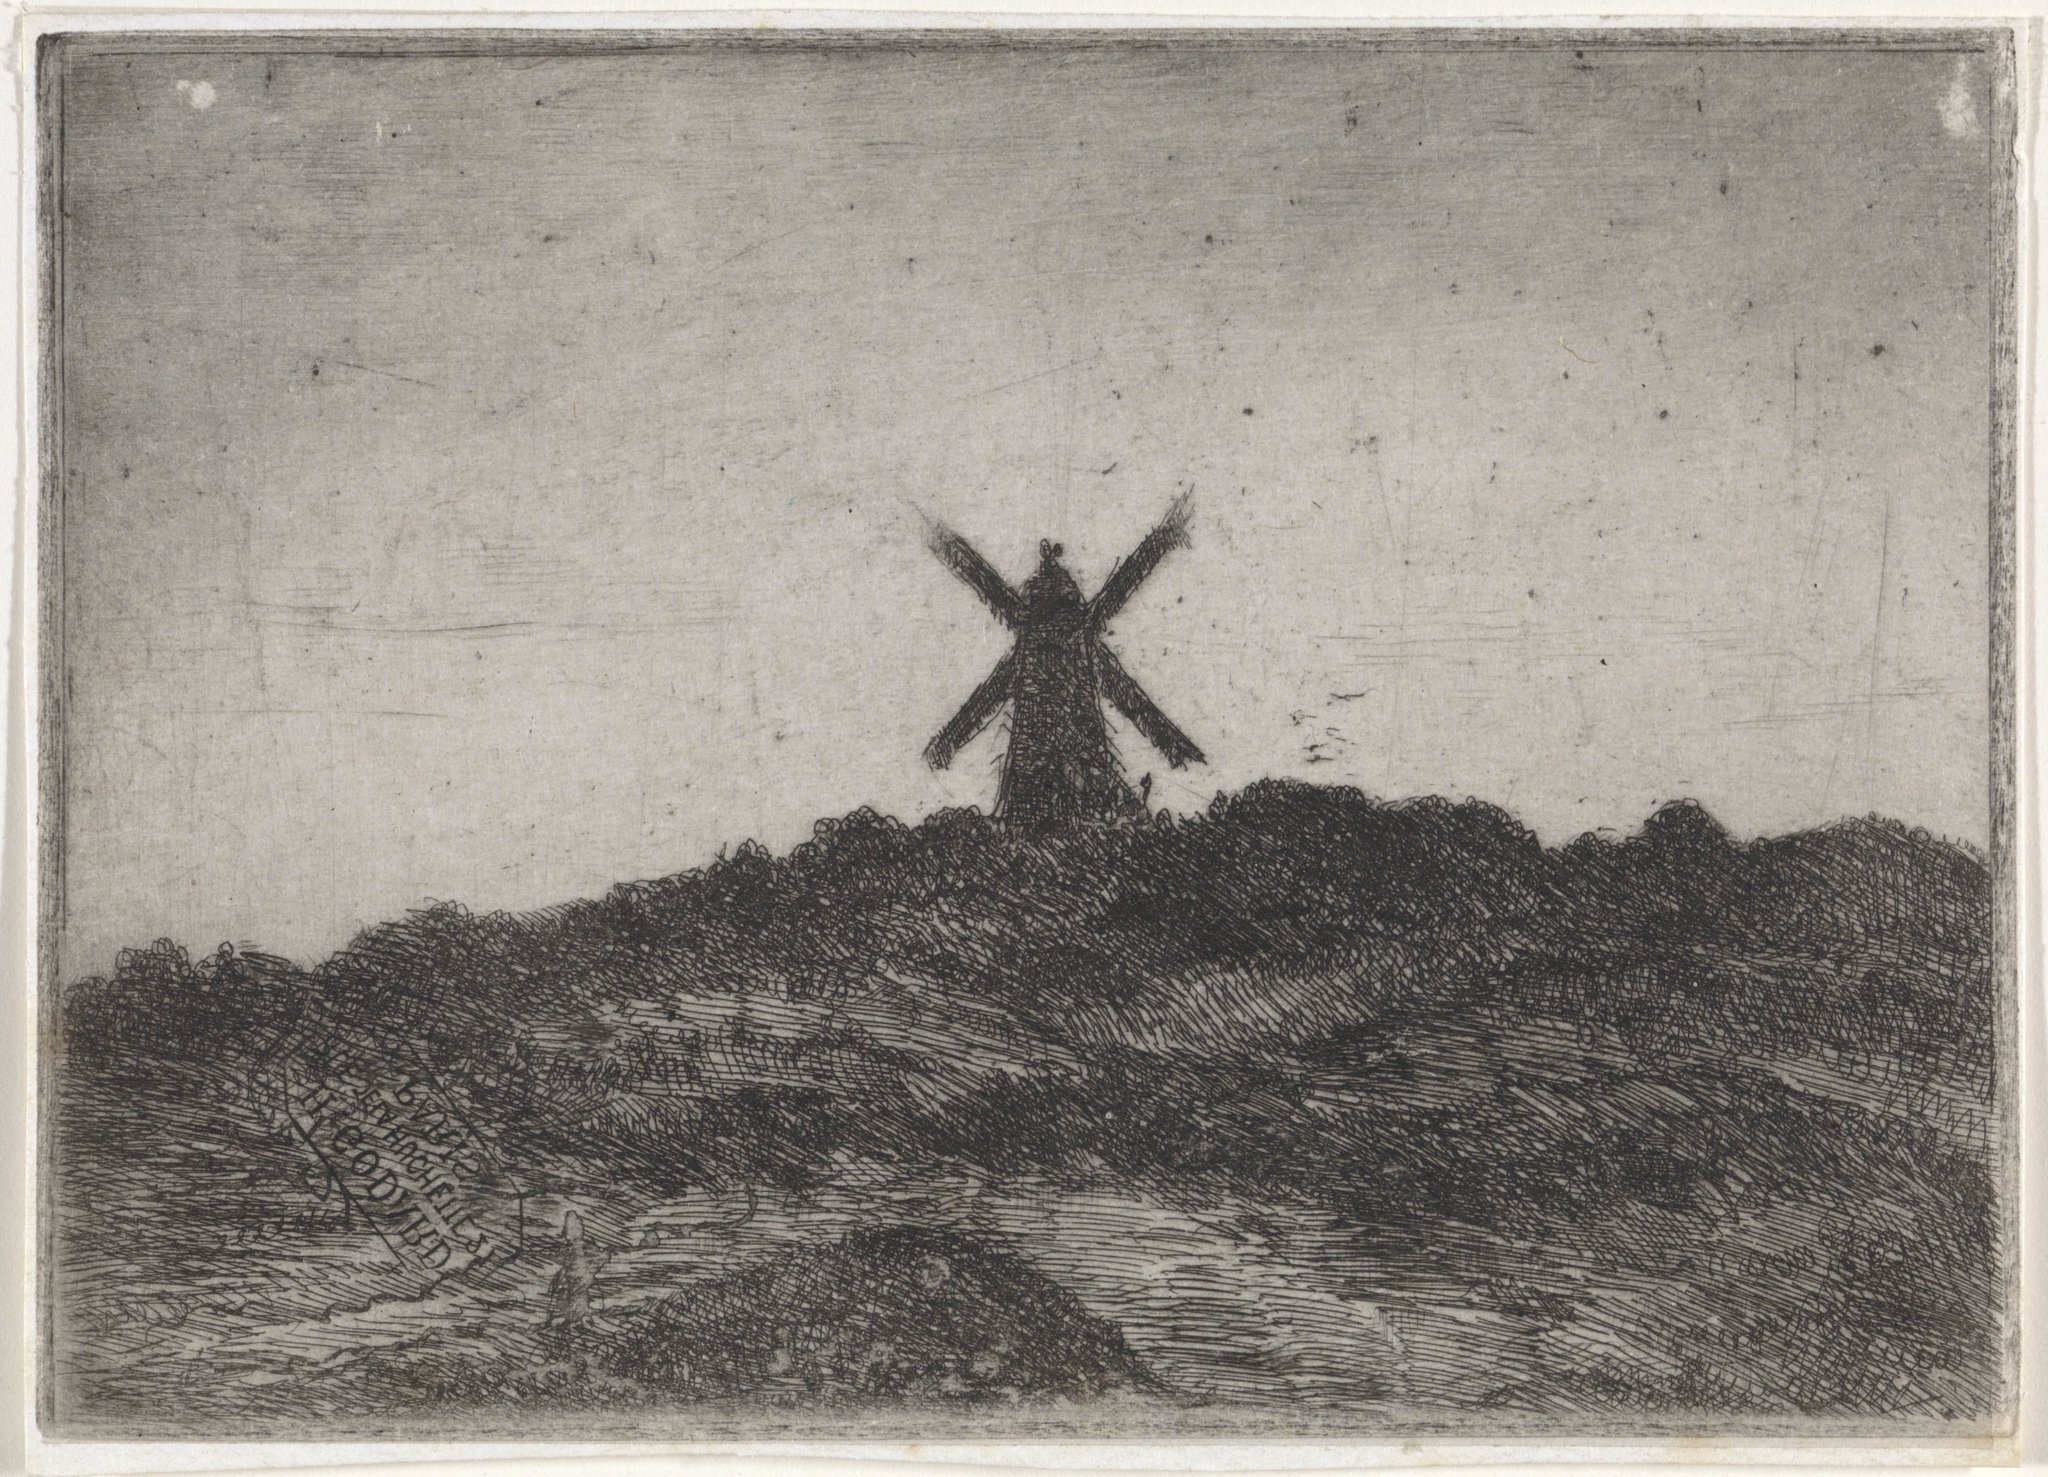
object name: print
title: Molen in een duinlandschap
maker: arnoud schaepkens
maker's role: print maker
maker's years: 1816-1904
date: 1855-1904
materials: paper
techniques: drypoint, etching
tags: dunes (sea not visible); in the dunes, watermill in landscape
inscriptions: collector's mark: Lugt 2228, stamp: ‘H.Godard / Rue de la Huchette 27 / Paris (in spiegelbeeld)’